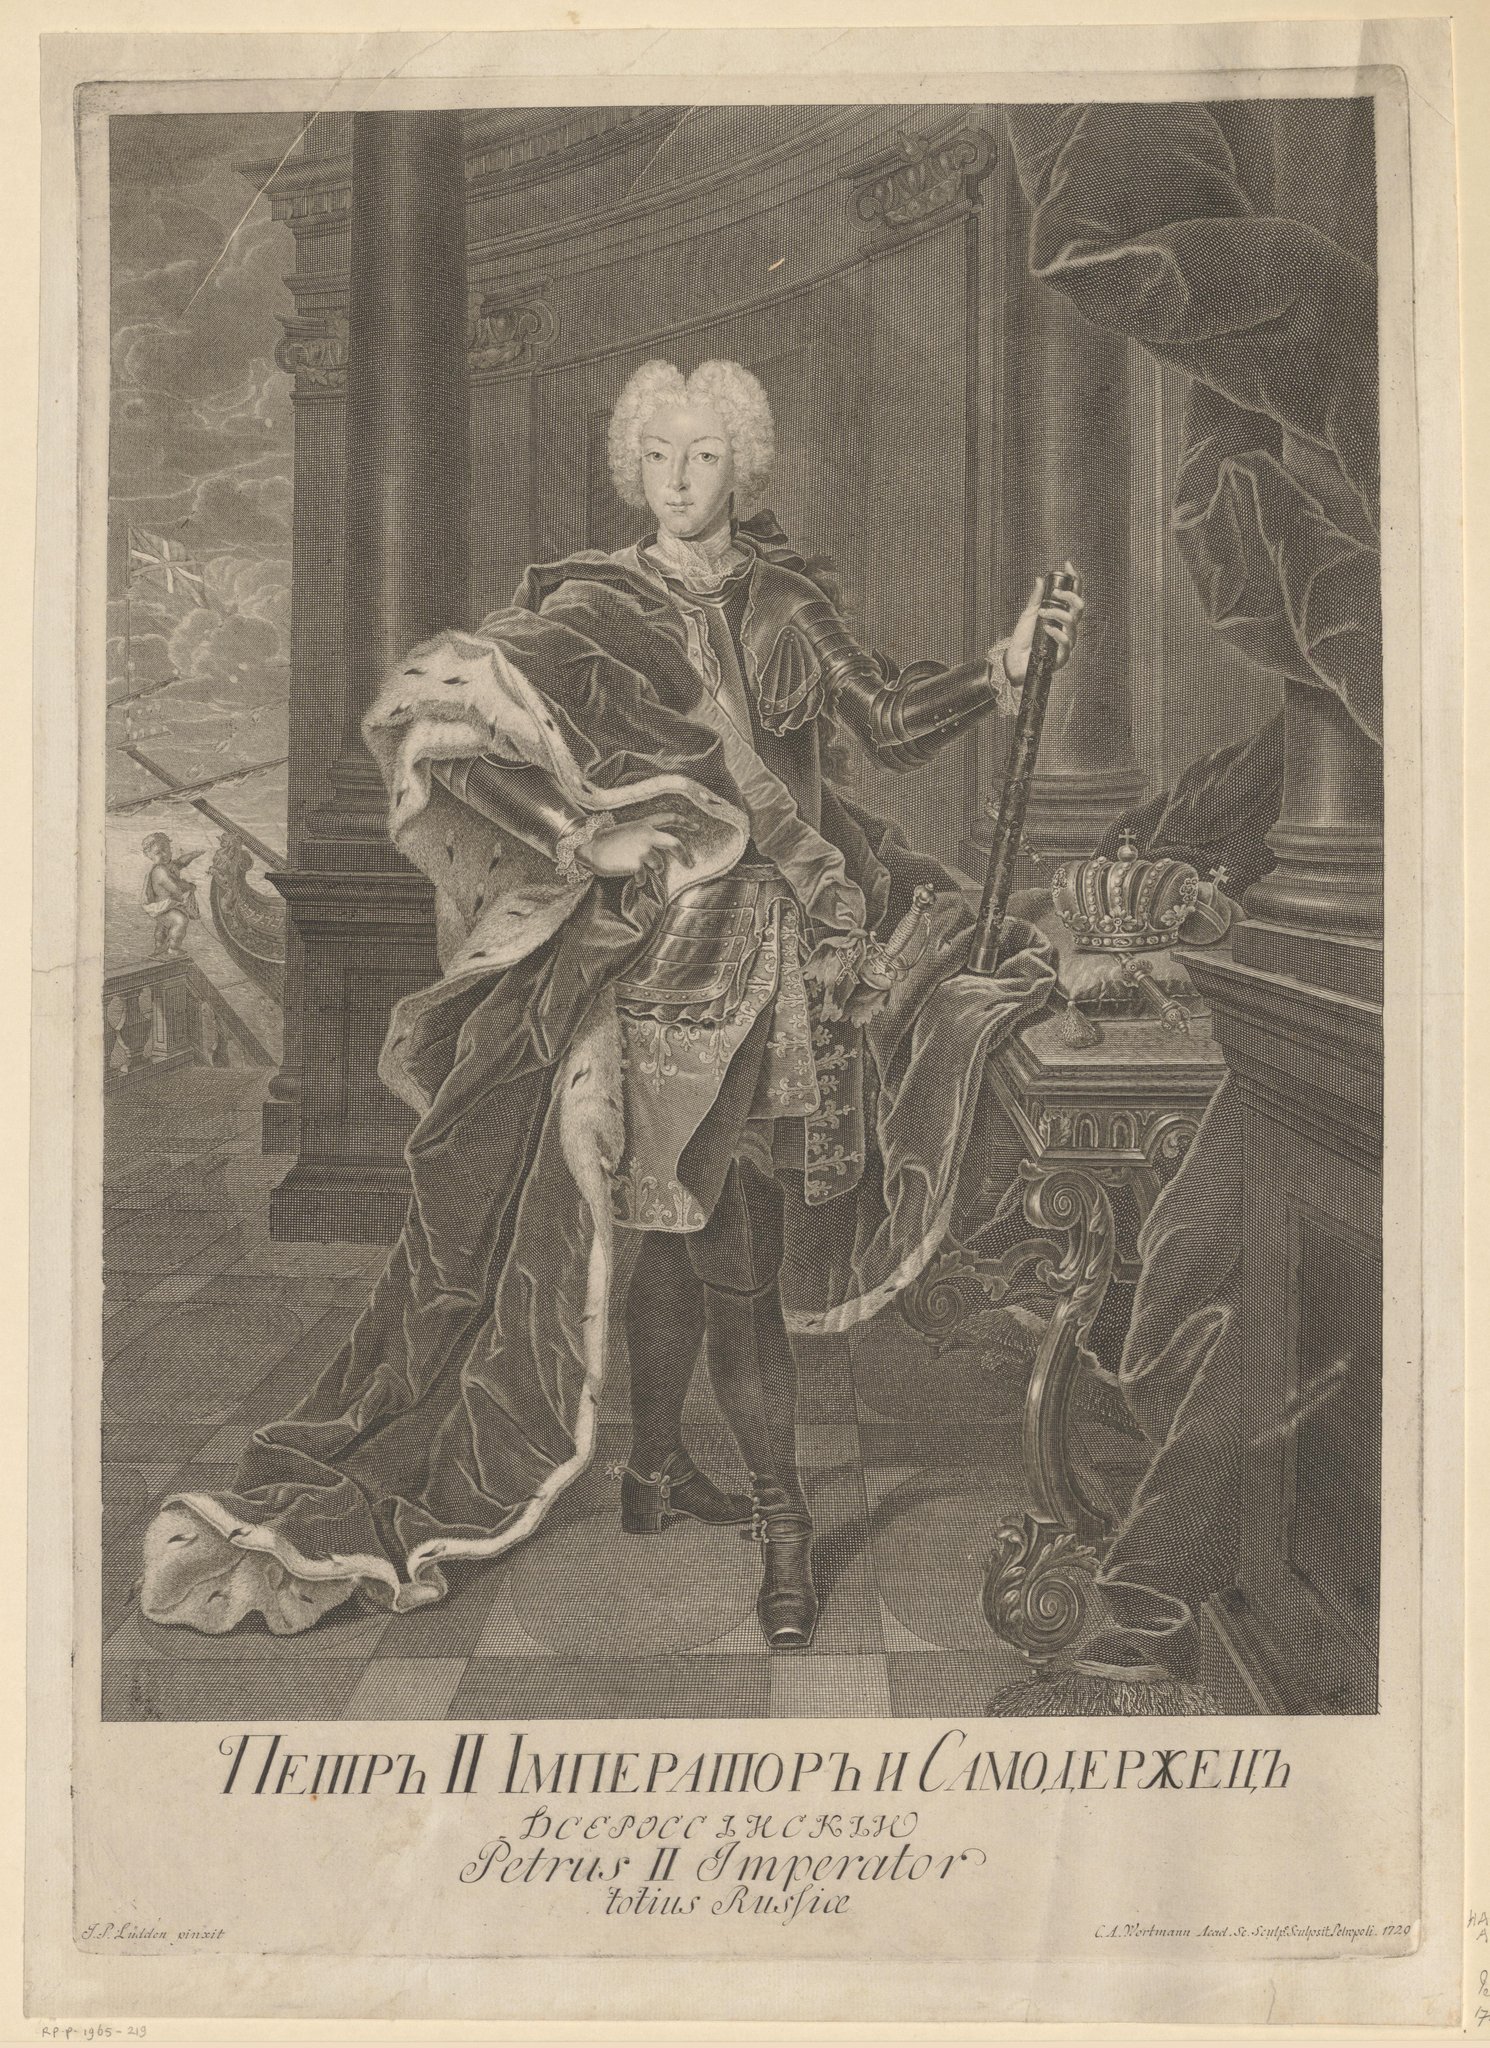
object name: print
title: Portret van Peter II, tsaar van Rusland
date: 1729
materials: paper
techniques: engraving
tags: adult man, historical persons, insignia and symbols of sovereignty (crown, diadem, sceptre, orb, seal, standard, cloak, pectoral)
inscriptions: watermark, collector's mark: Lugt 2228